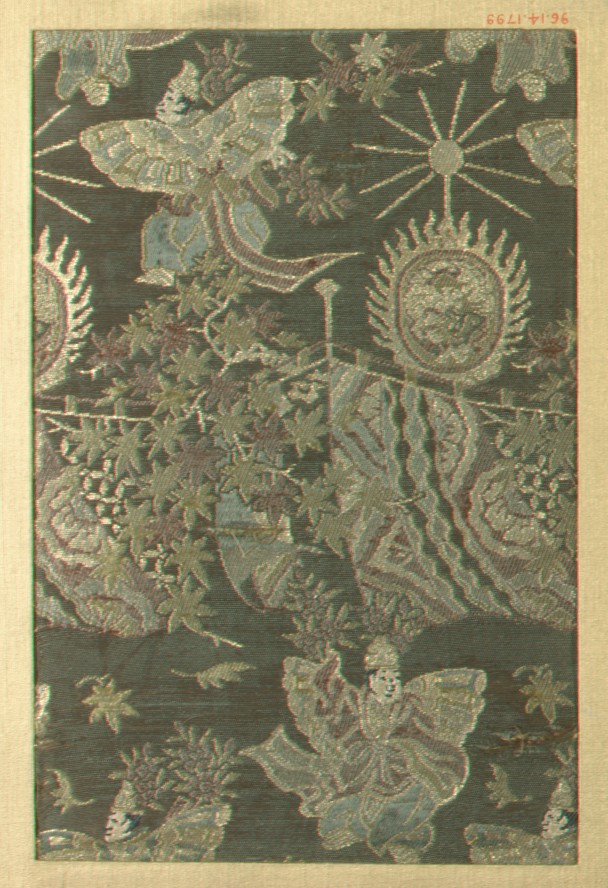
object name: piece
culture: japanese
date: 1701-1900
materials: silk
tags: leaves